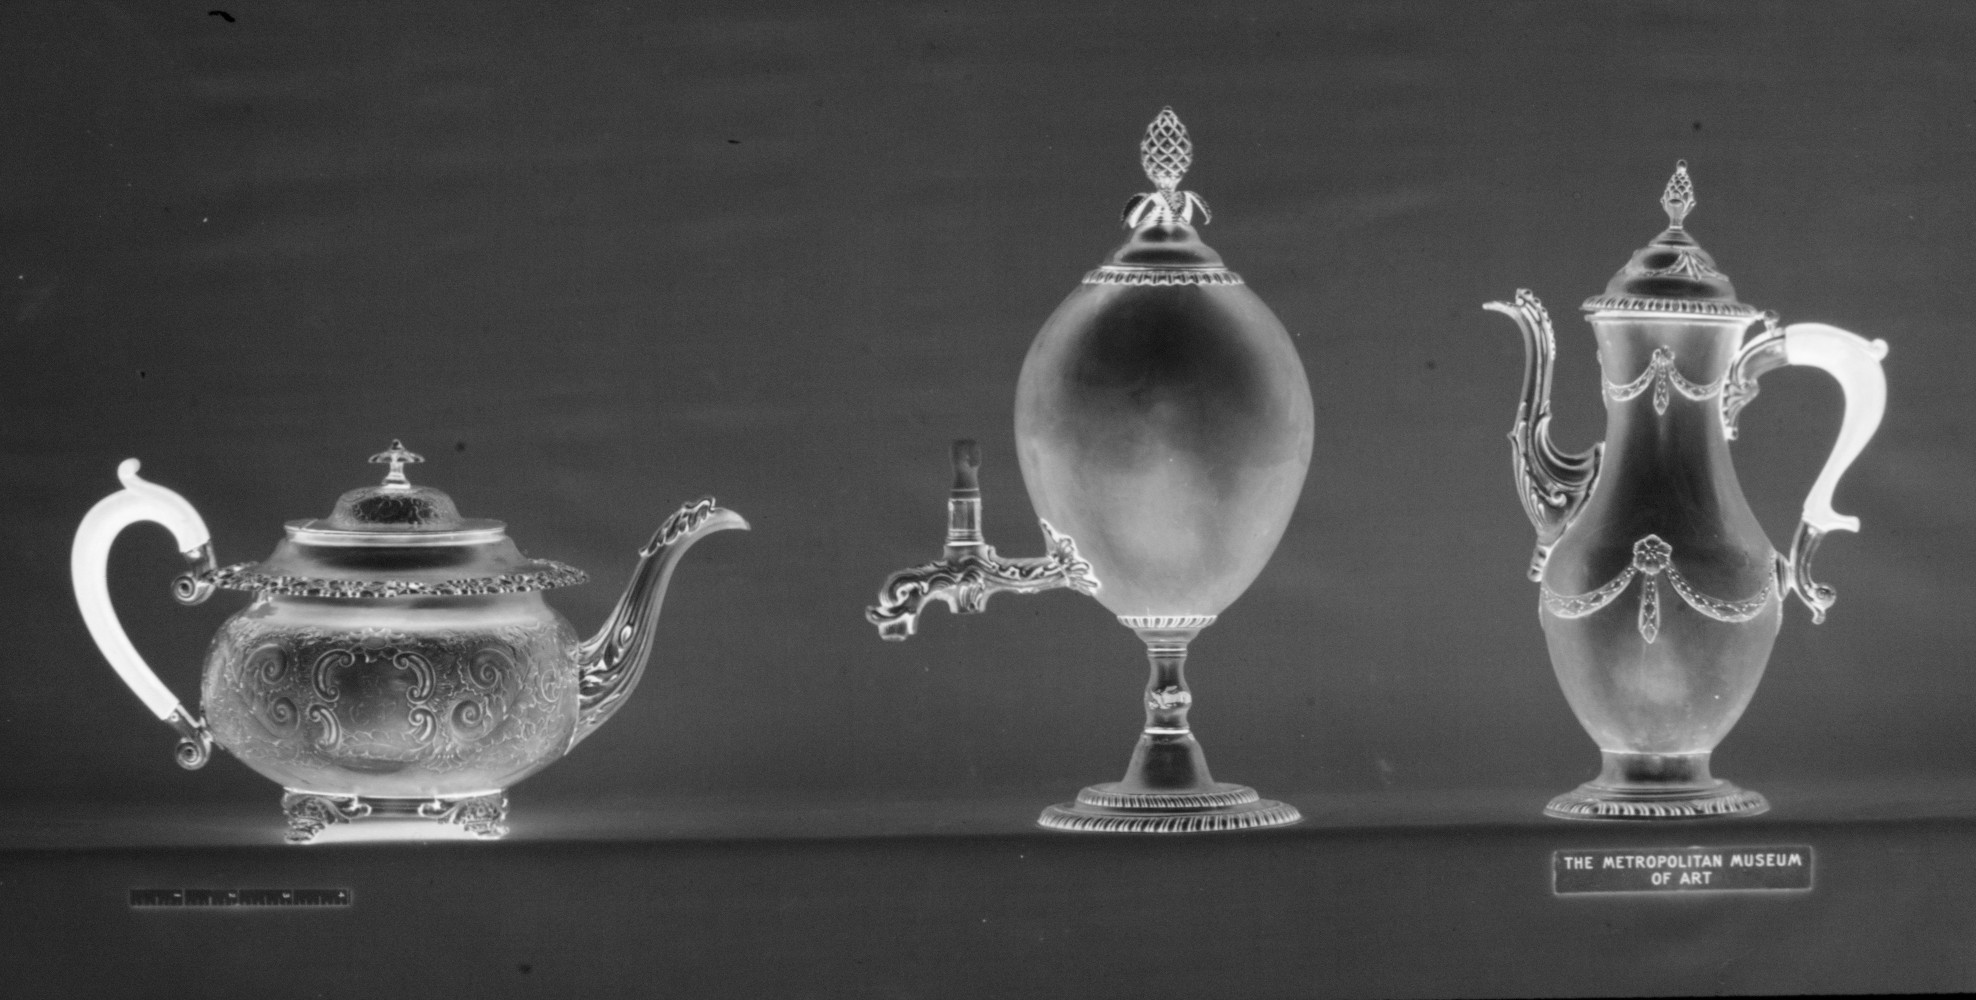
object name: coffeepot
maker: richard morton and co.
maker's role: maker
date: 1765-1770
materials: metal